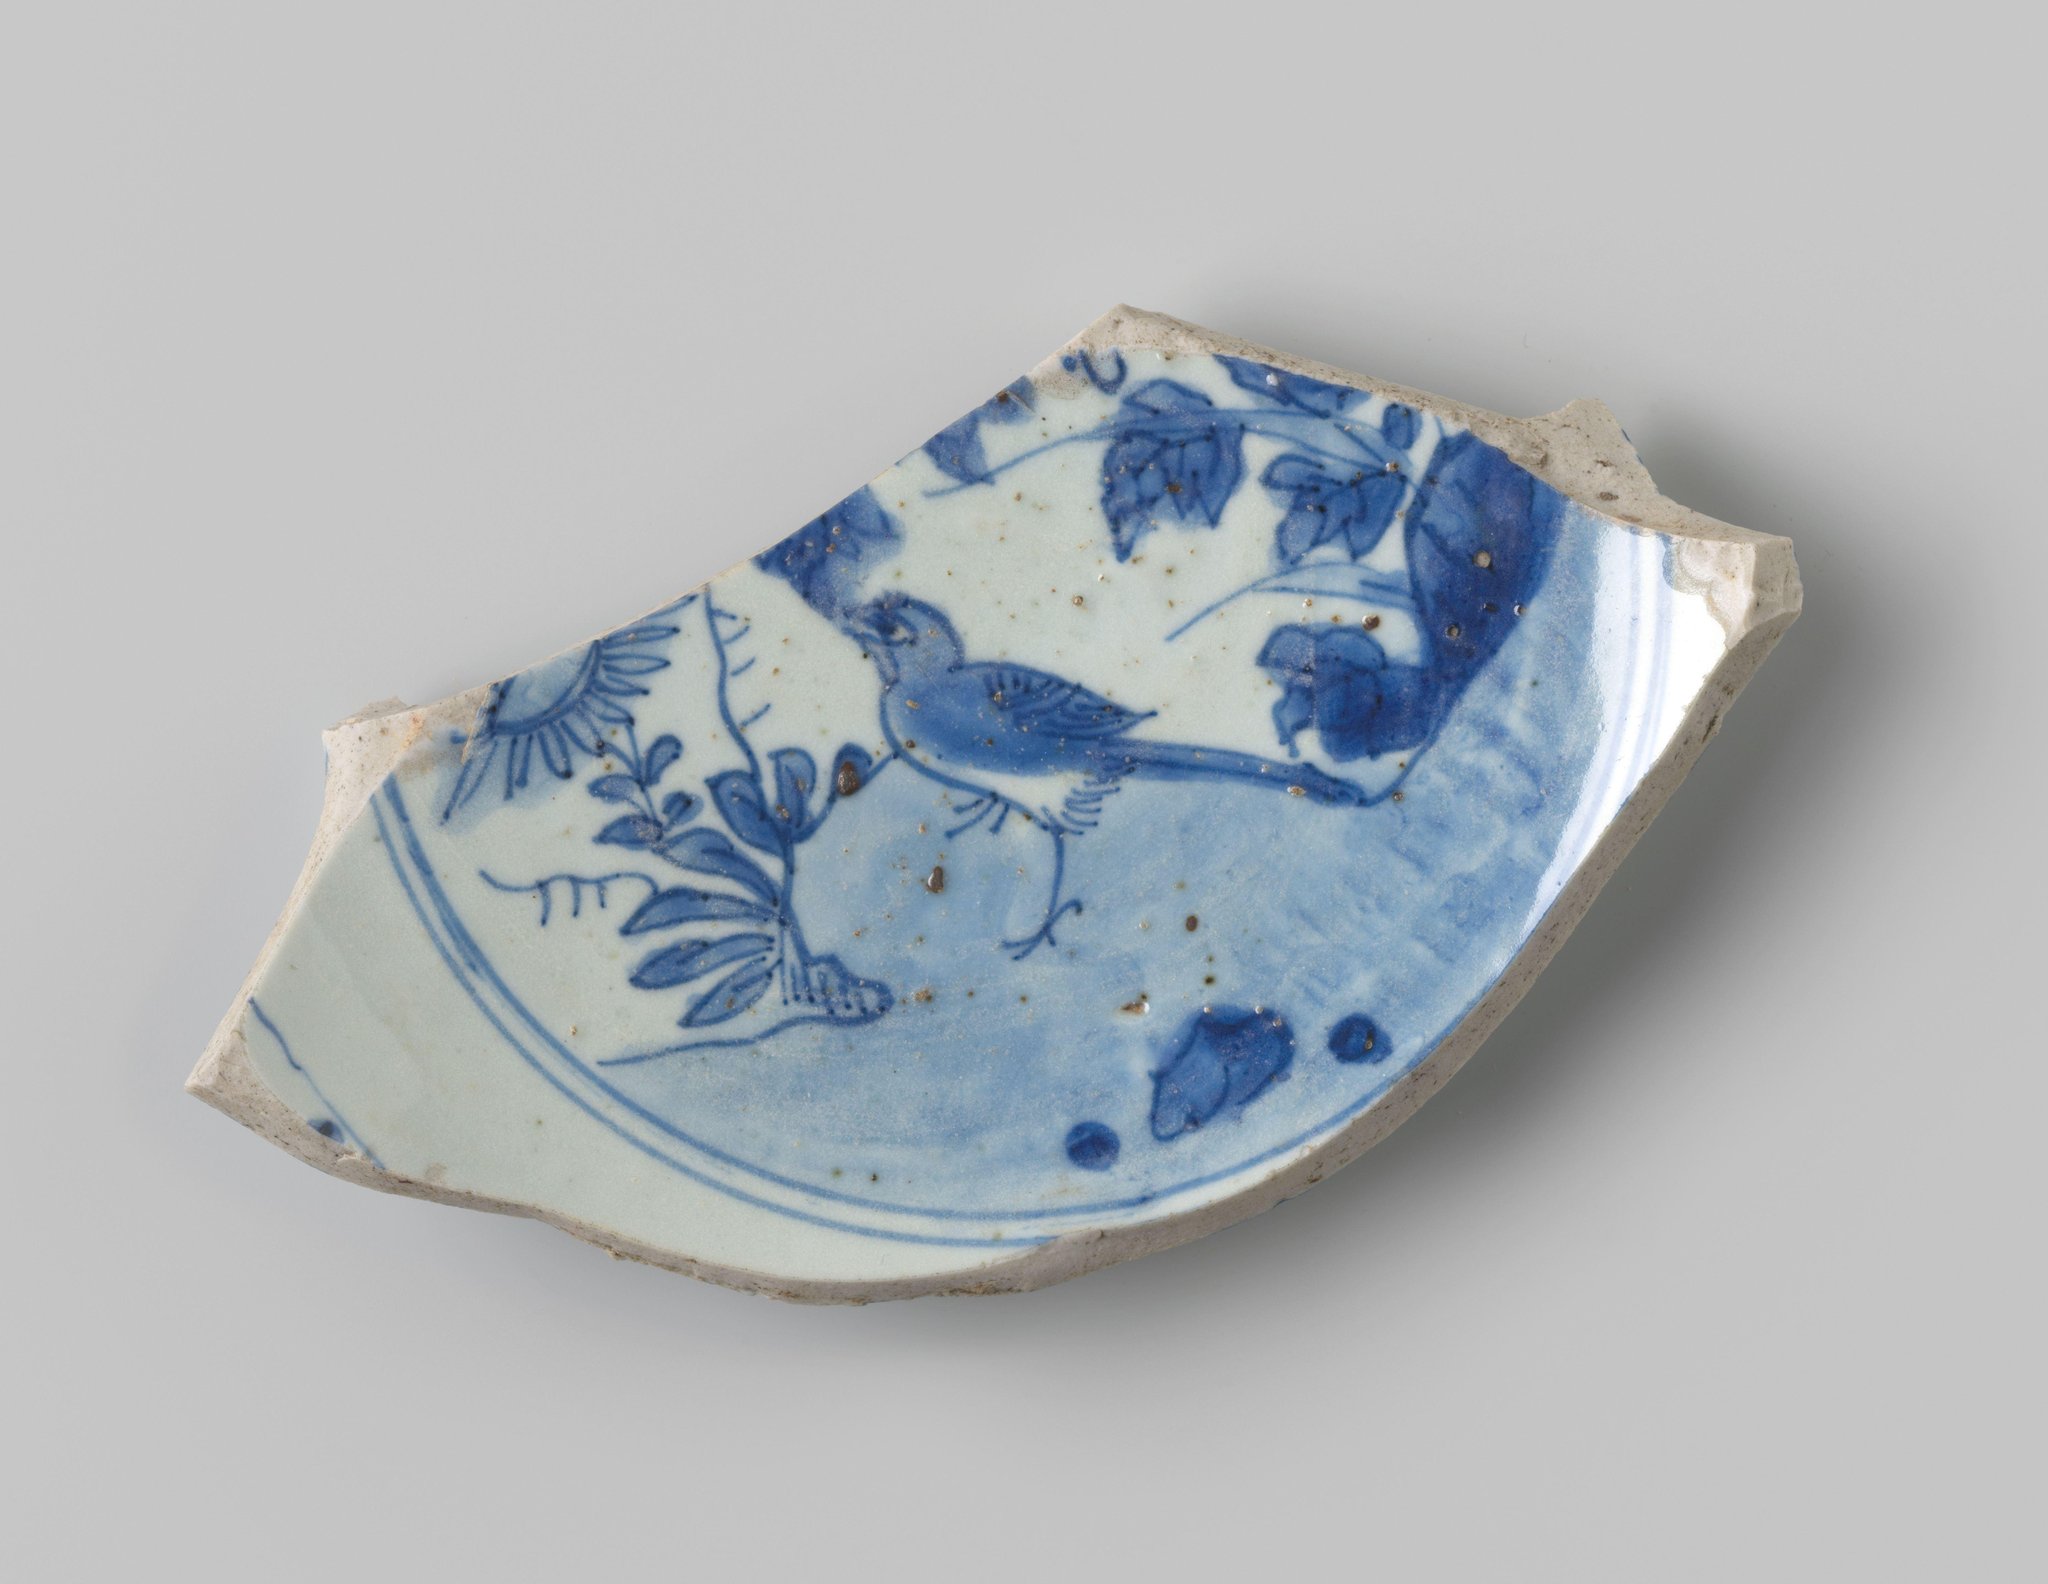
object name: fragment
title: Sherd with a bird on a rock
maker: Anonymous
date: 1600-1624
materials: cobalt, glaze, paint, porcelain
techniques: firing, turning, vitrification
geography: china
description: Scherf van porselein, beschilderd in onderglazuur blauw met een vogel op een rots bij bloeiende planten. Dubbele blauwe lijn en bakzand op de voetring. Kraakporselein.